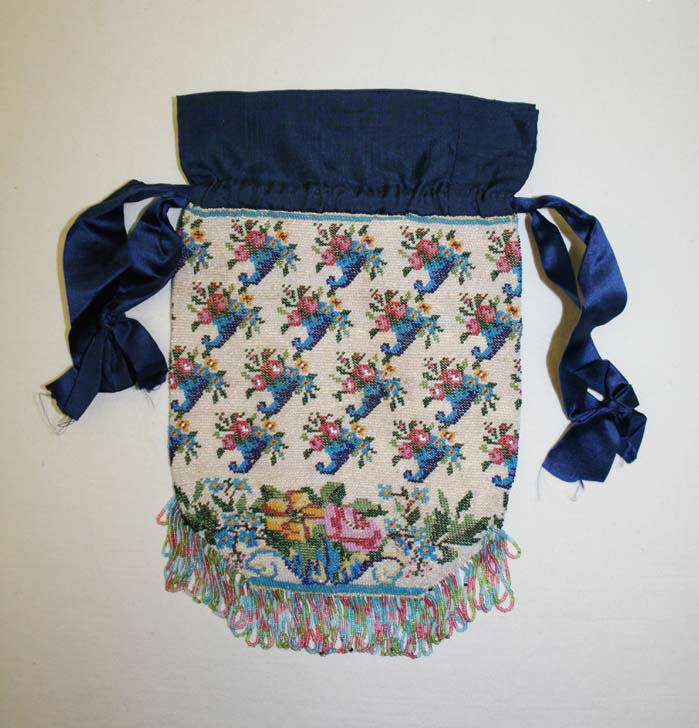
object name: drawstring bag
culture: american or european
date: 1875-1889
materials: silk